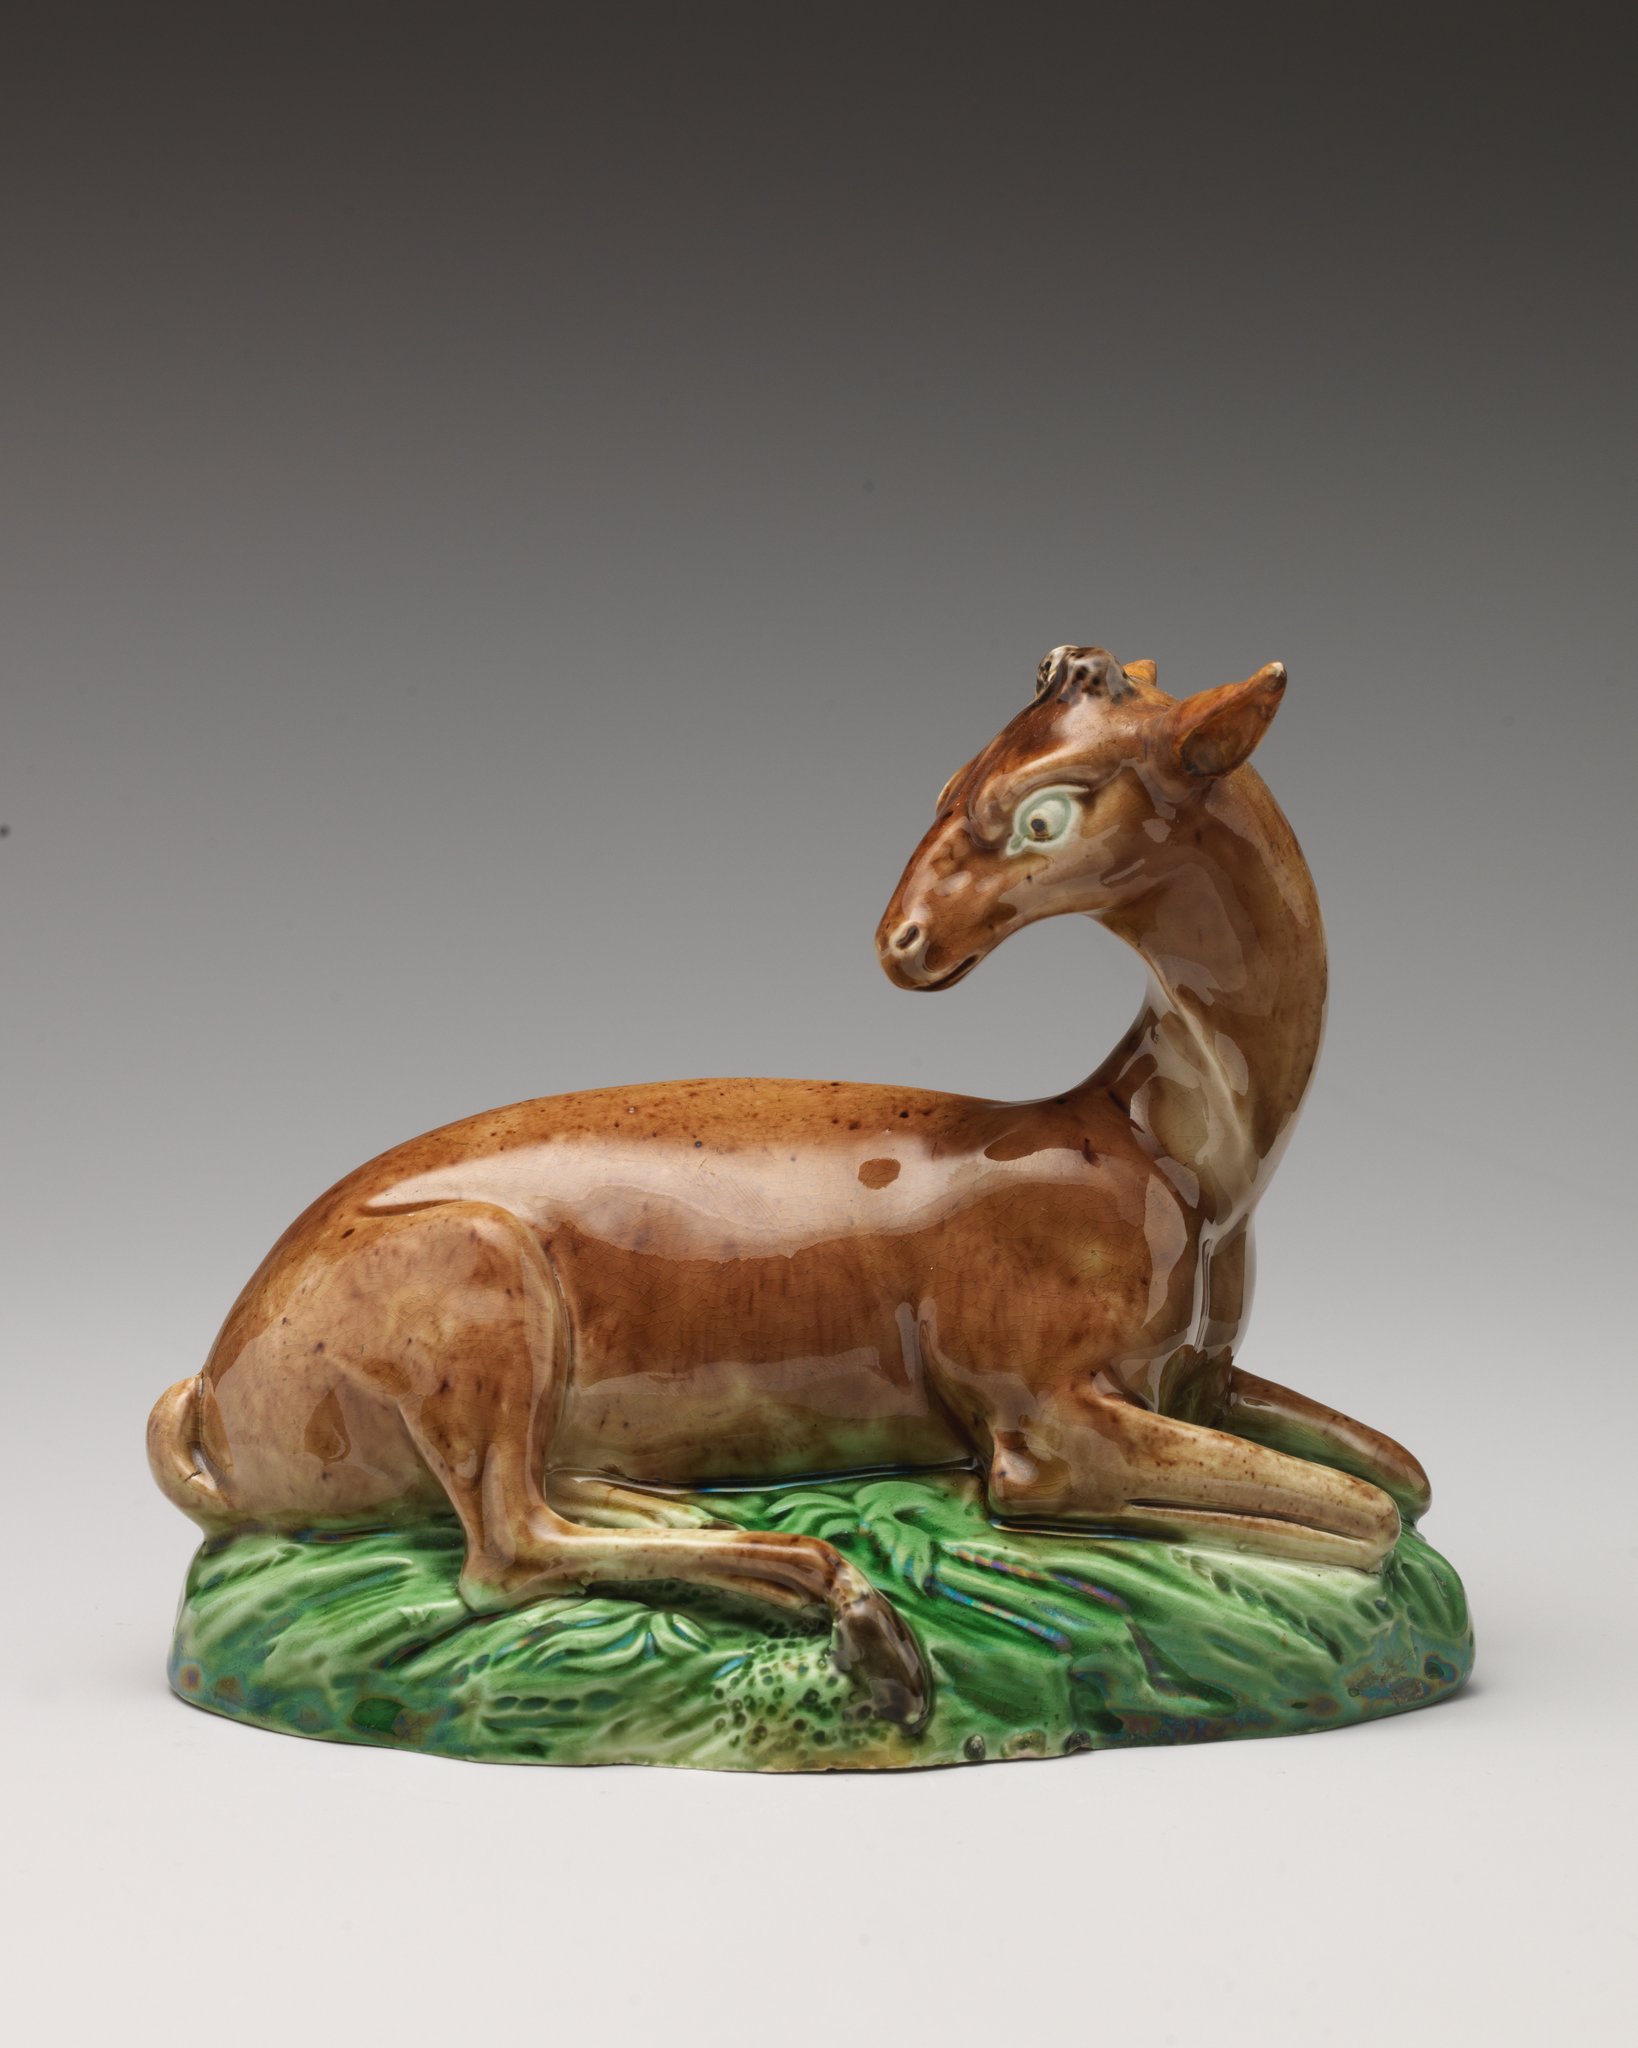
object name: figure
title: Doe (one of a pair)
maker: ralph wood the younger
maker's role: maker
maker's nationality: british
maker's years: 1748-1795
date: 1780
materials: earthenware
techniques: glazing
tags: deer